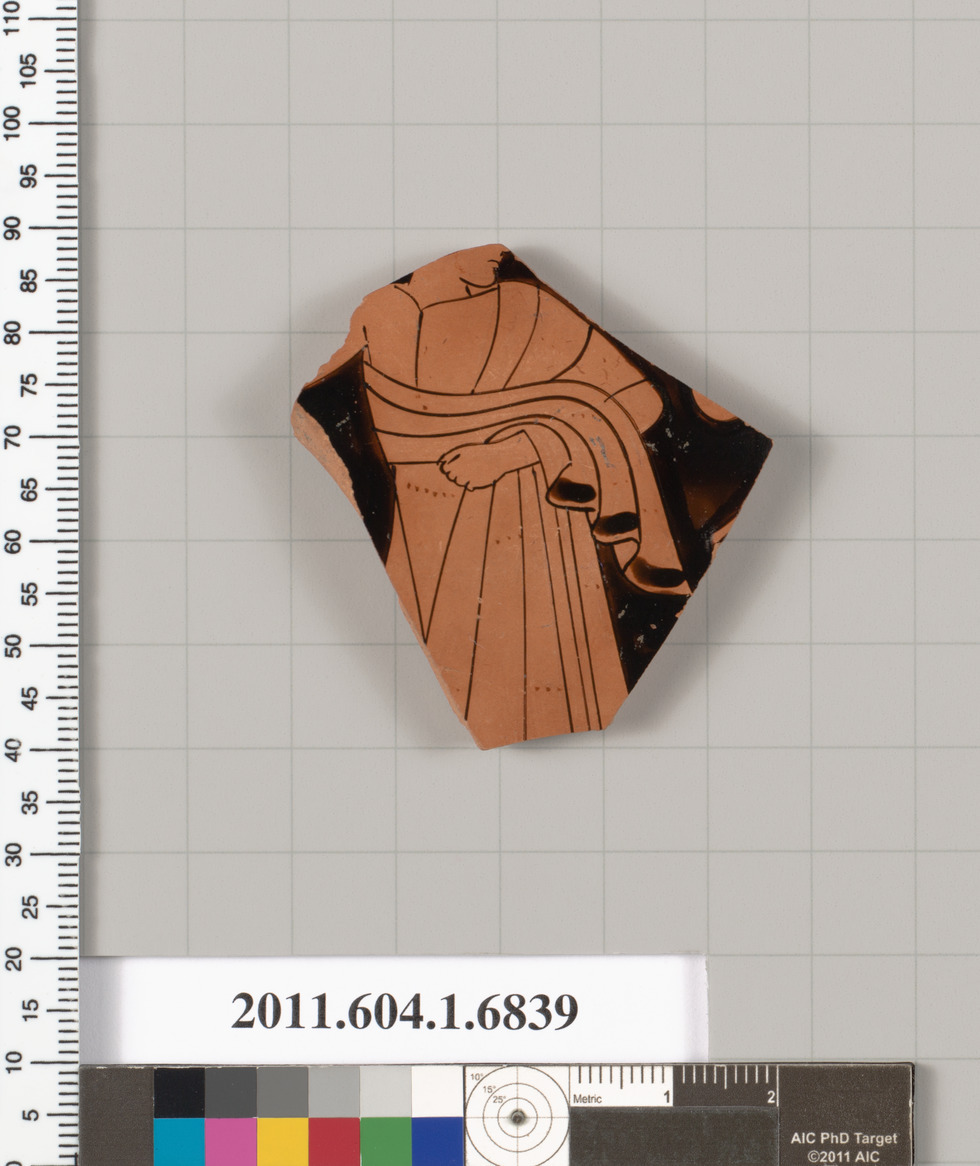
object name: kylix fragment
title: Terracotta fragment of a kylix (drinking cup)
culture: greek, attic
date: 490-470 BCE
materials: terracotta